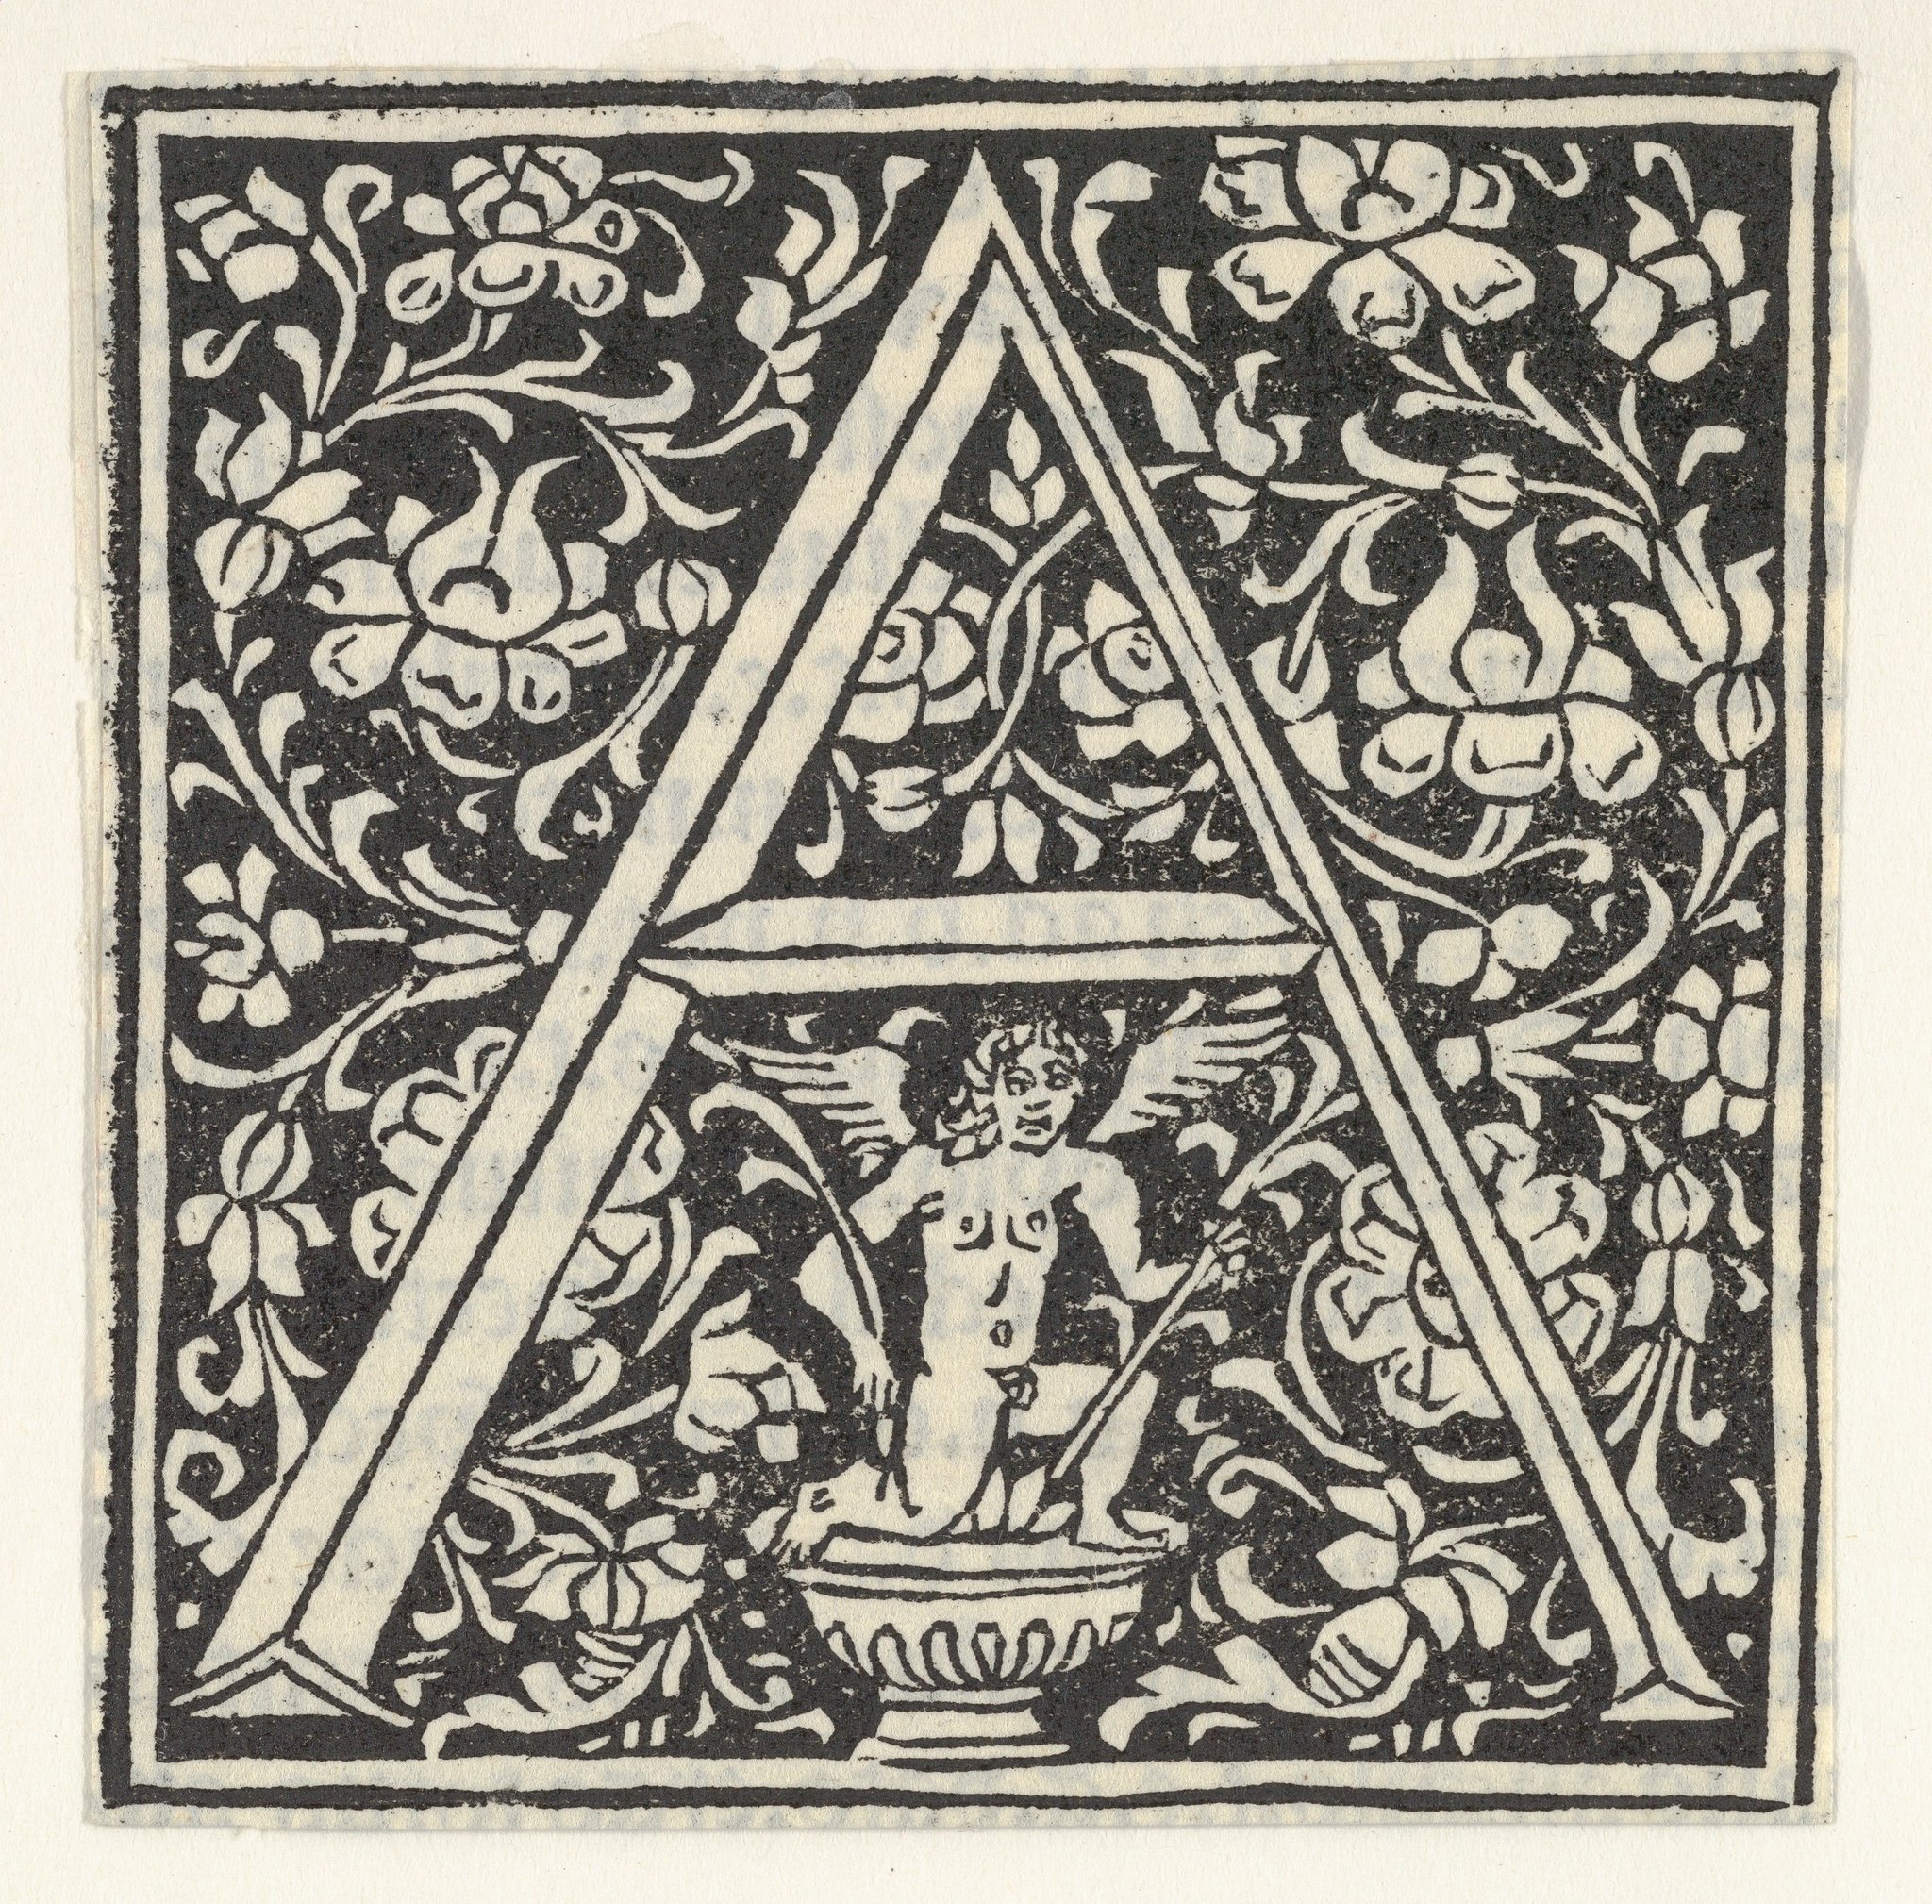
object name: print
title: Initial letter A with putto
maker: anonymous, italian, 15th century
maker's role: artist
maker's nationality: italian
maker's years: 1400-1500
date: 1496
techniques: woodcut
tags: flowers